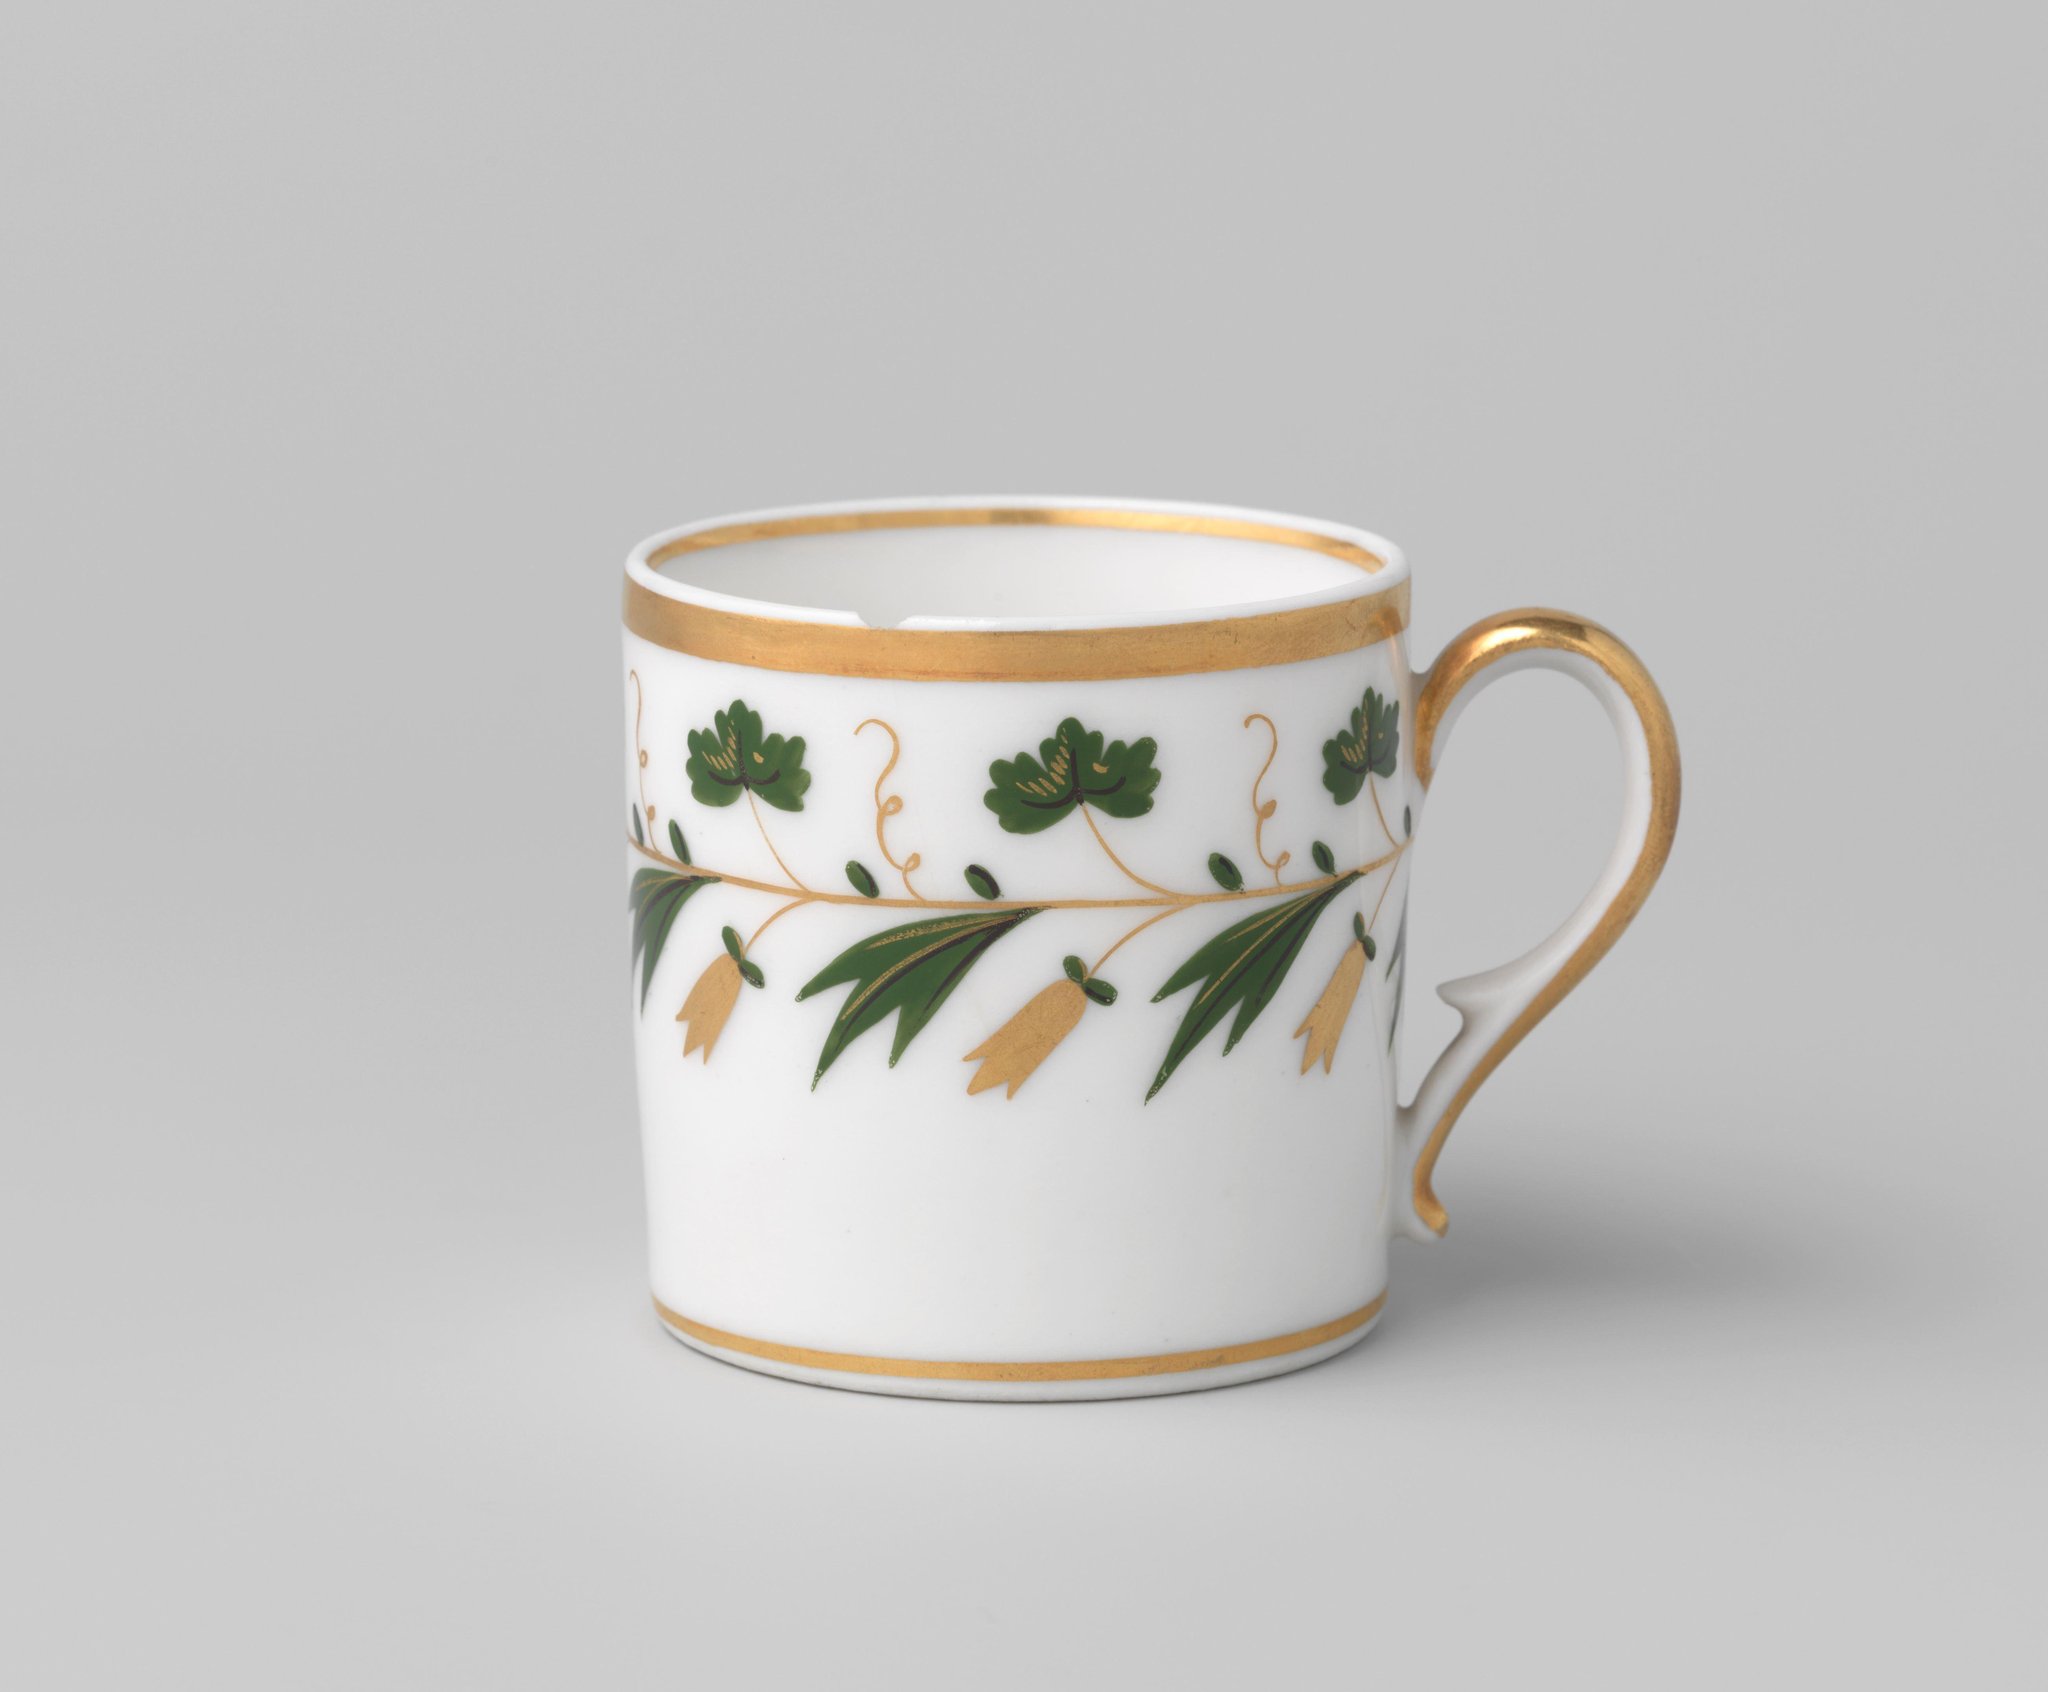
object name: cup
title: Cup with a border of grapevines and flowers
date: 1800-1824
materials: glaze, gold, paint, porcelain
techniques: firing, forming, gilding, turning, vitrification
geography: paris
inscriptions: mark: ‘gekruiste pijlen’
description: Kop van porselein met een cilindrische wand en C-vormig oor, beschilderd op het glazuur in groen, zwart en goud. Op de buitenwand een band met aan de ene zijde wijnranken en aan de andere zijde bloemen en bladeren. Gouden rand, voet en oor. Gemerkt op de onderzijde met de gekruiste pijlen.